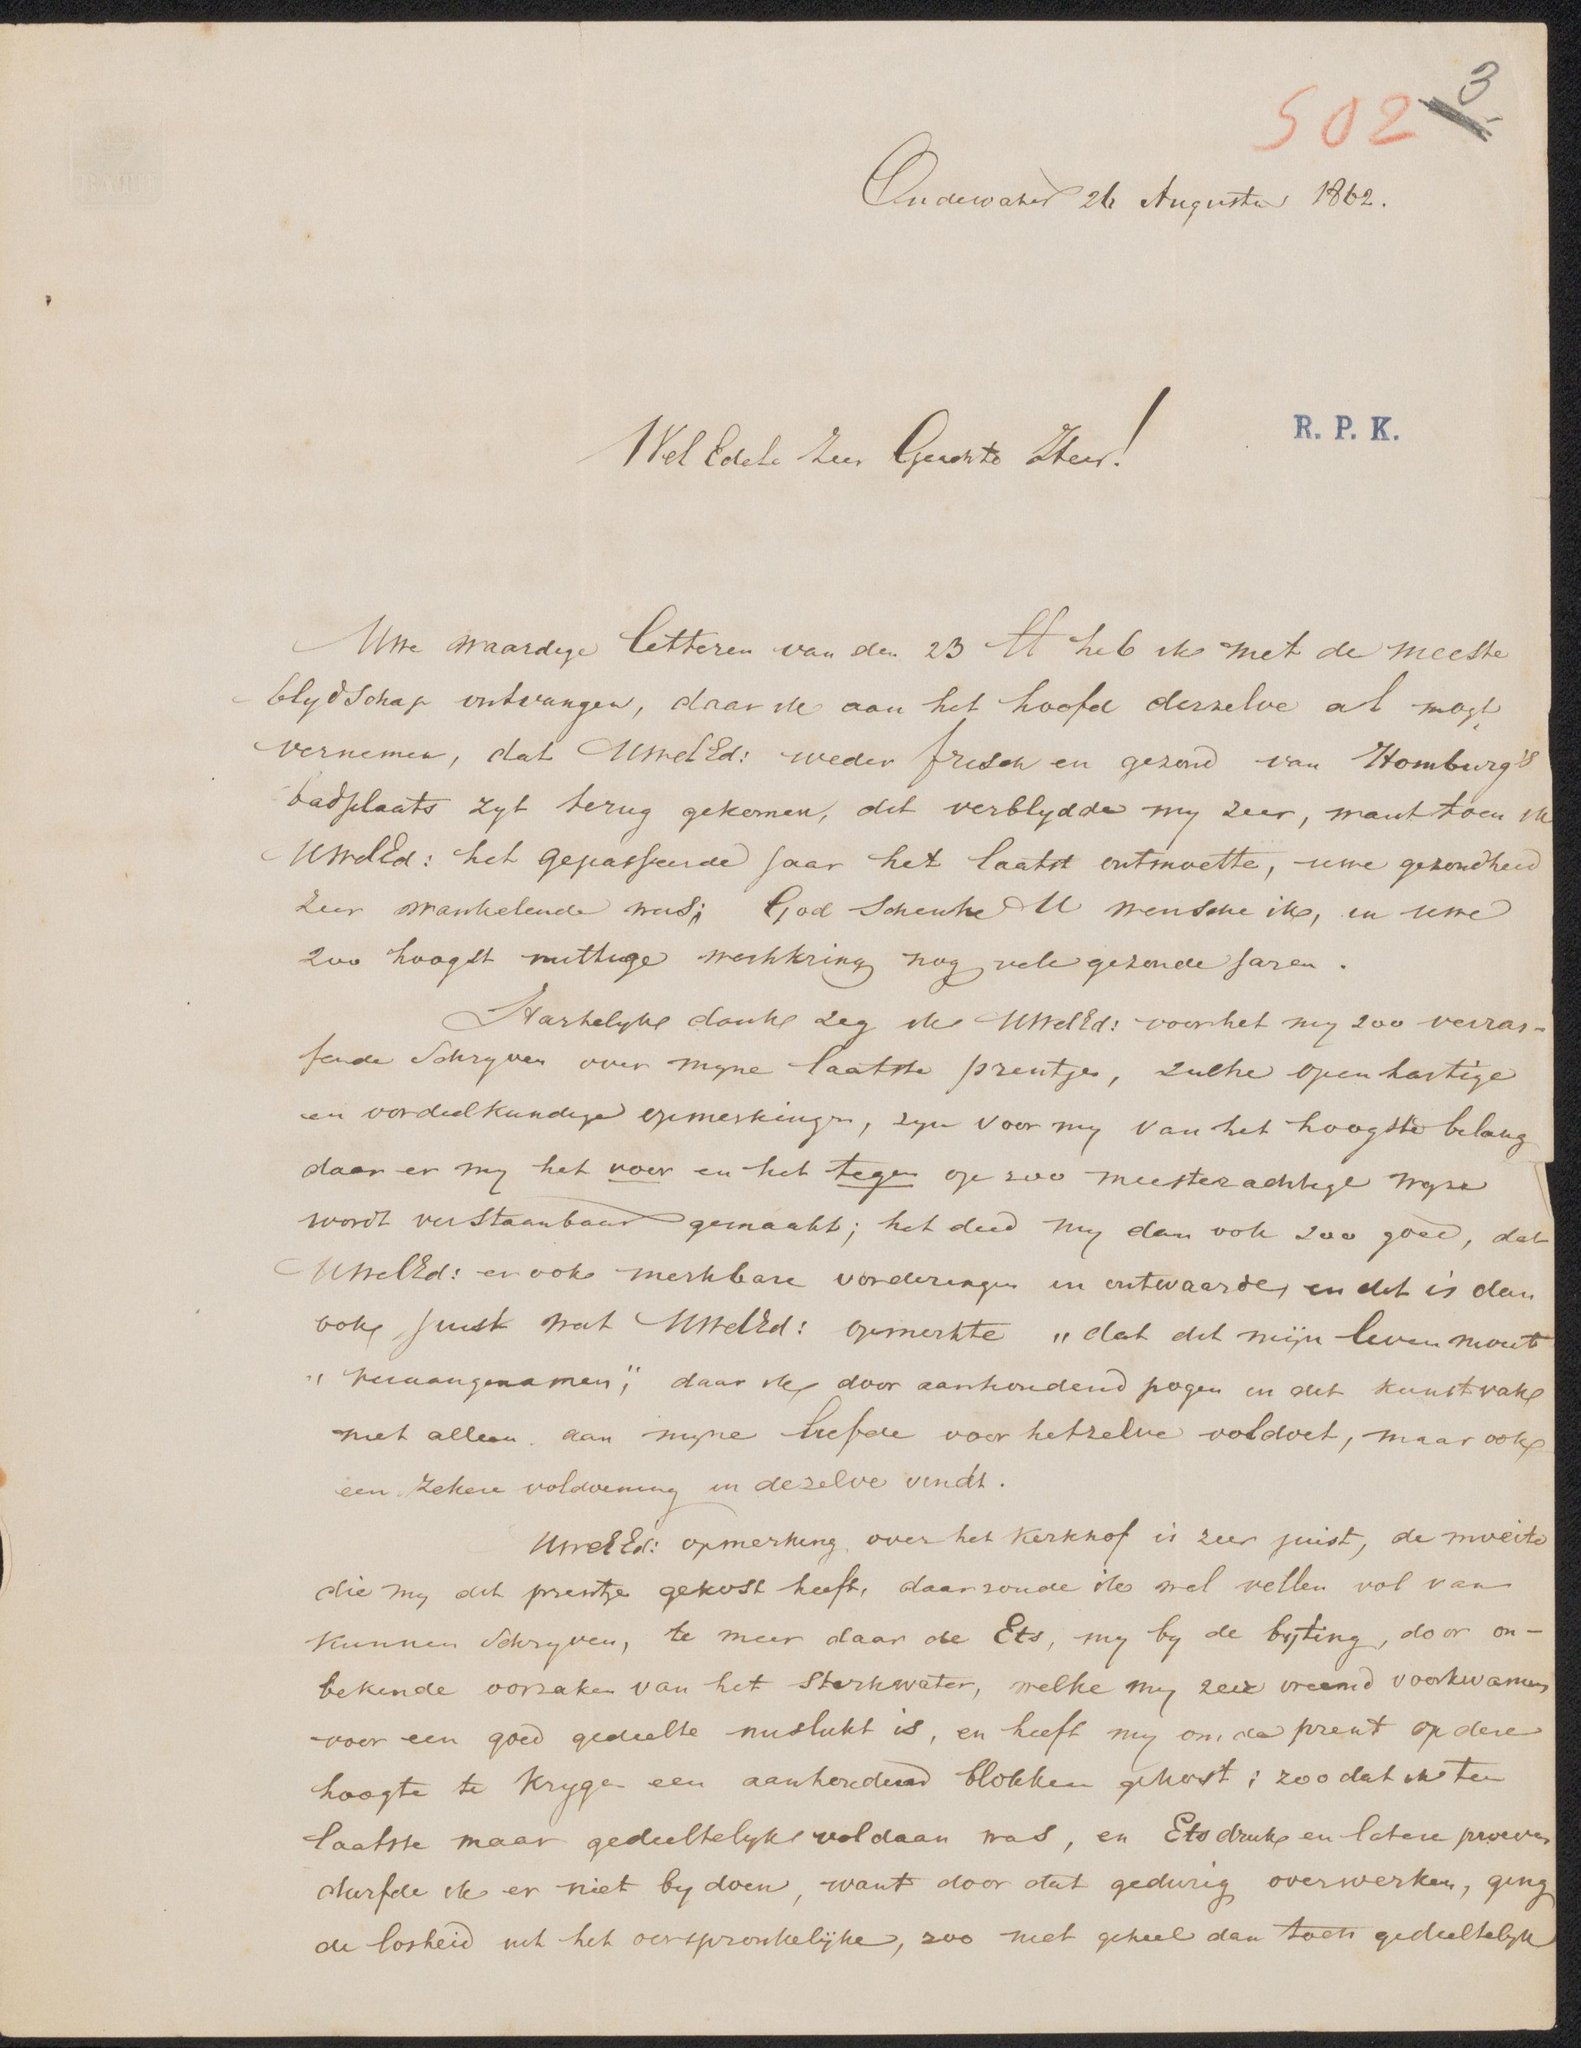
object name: letter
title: Brief aan Christiaan Kramm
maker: eberhard cornelis rahms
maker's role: print maker, publisher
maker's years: 1823-1907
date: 1862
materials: ink, paper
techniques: pen, writing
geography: oudewater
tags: draughtsman, christiaan kramm, the graphic arts, painting (including book-illumination, miniature-painting)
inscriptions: collector's mark: Lugt 2233